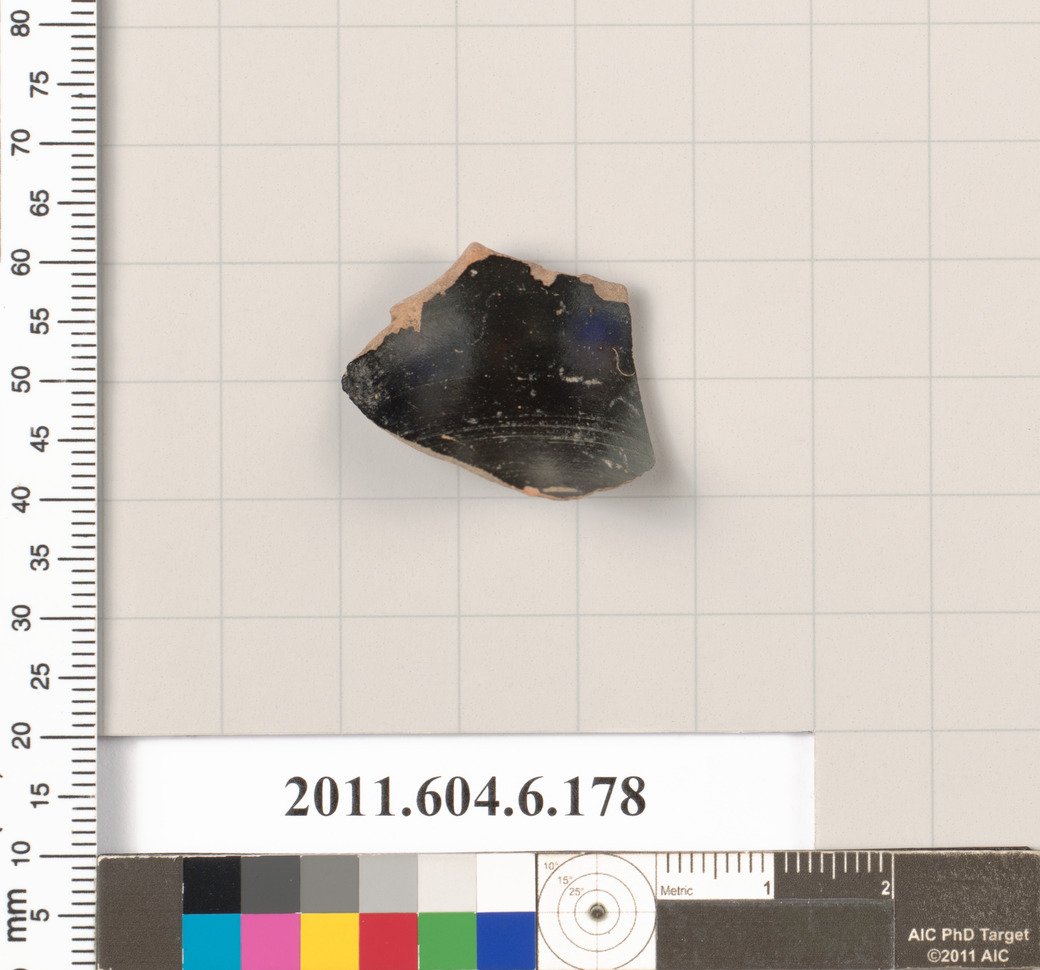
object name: oinochoe fragment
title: Terracotta fragment of an oinochoe (jug)?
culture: greek, attic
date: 500-401 BCE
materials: terracotta